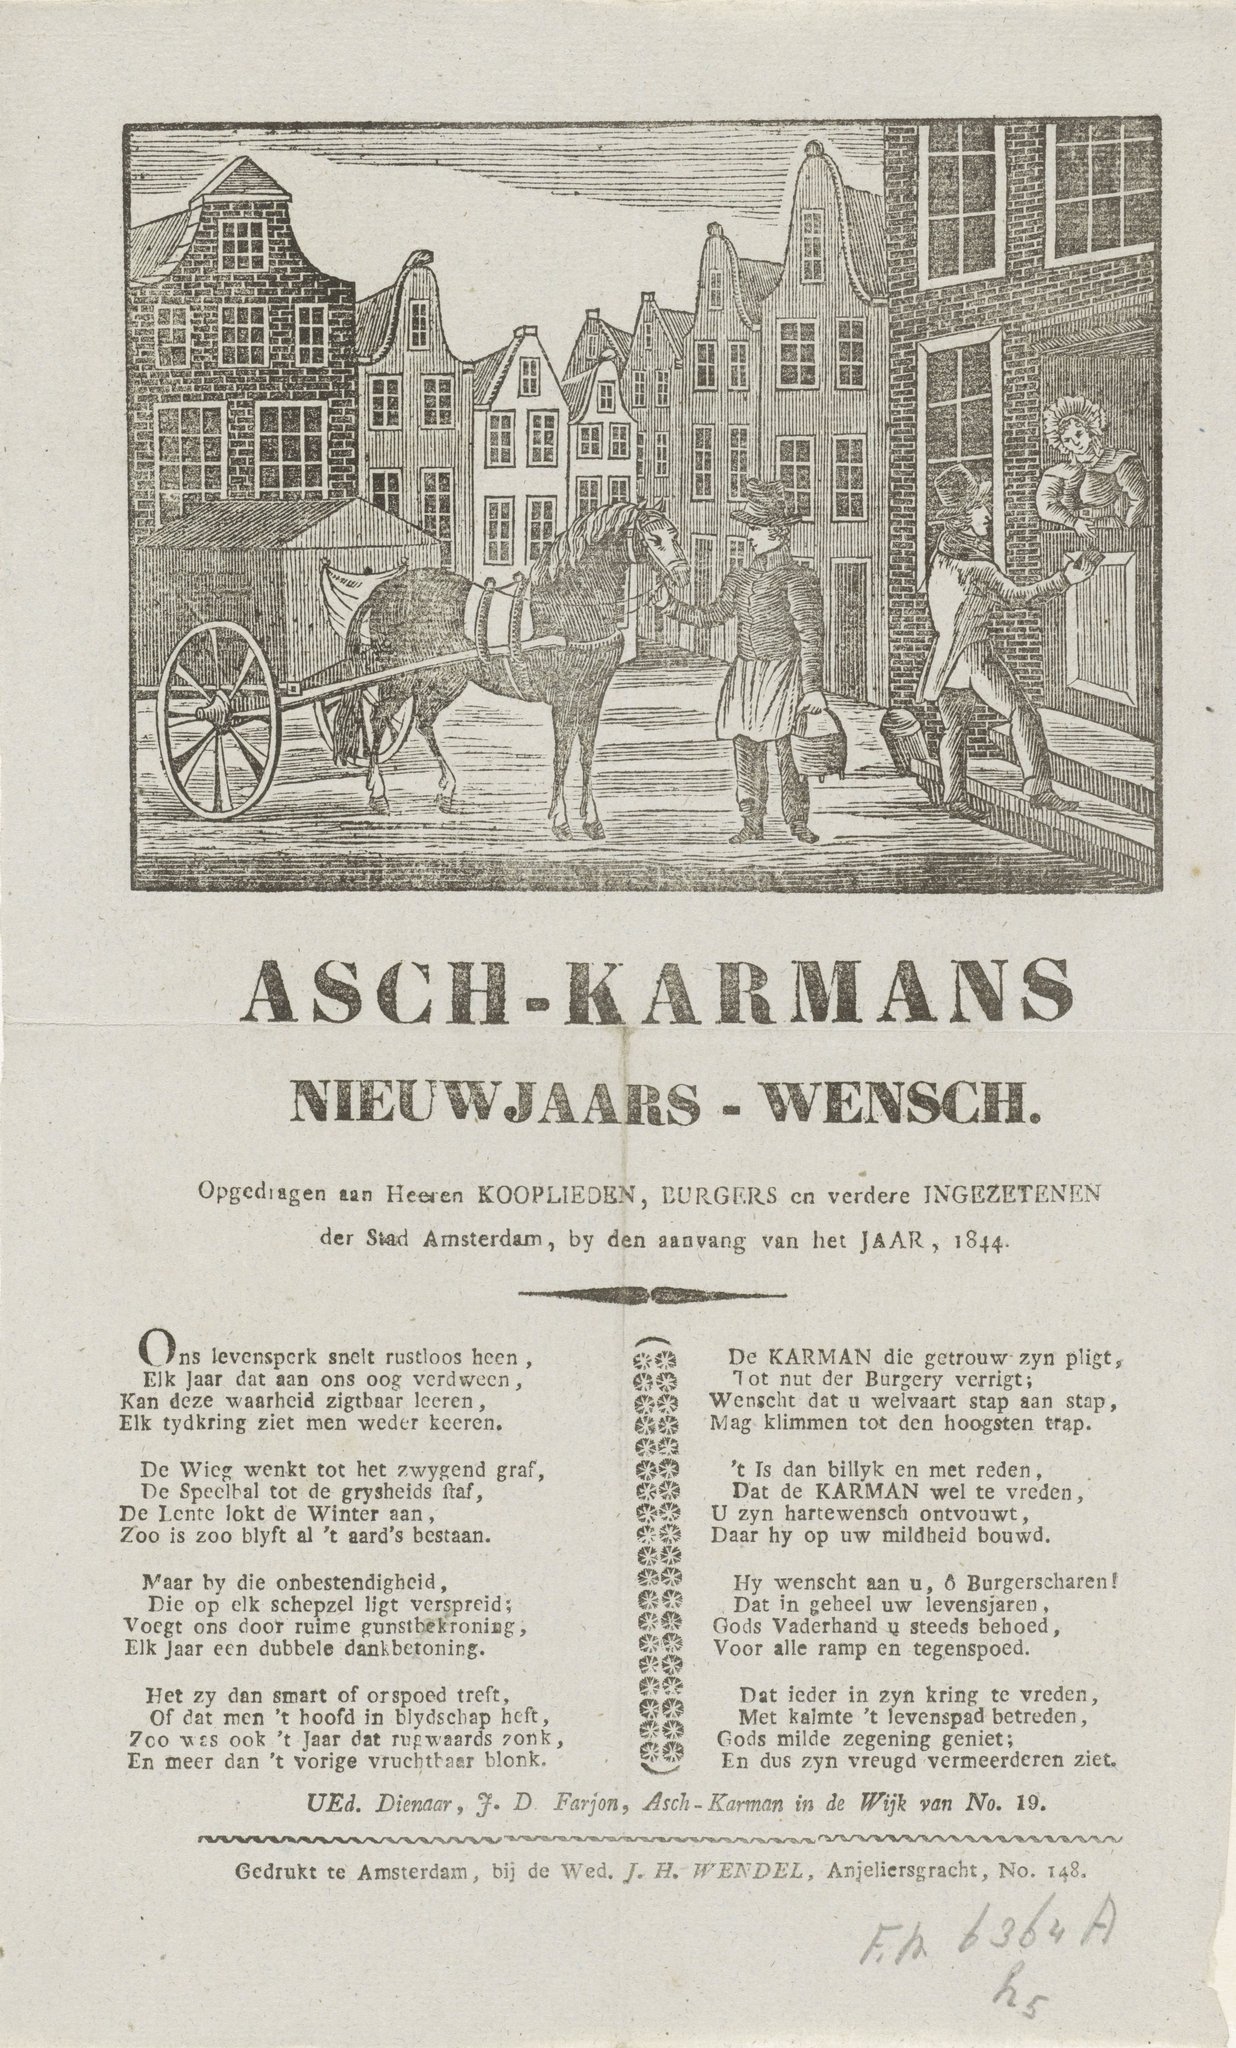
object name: new year card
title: Nieuwjaarswens van de Amsterdamse askarrenmannen voor het jaar 1844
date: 1843-1844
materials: paper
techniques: letterpress printing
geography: amsterdam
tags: public road - ii - ideal city, garbage collection, amsterdam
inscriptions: collector's mark: Lugt 2228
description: Nieuwjaarswens namens de askarrenmannen (karrenman of vuilnisman) te Amsterdam voor het jaar 1844. Gezicht in een straat te Amsterdam met een man staande met een asemmer bij de kar terwijl een andere man aan huis geld ophaalt. Onderaan een gedicht in twee kolommen. Namens J.D. Farjon, de askarreman van wijk no. 19.